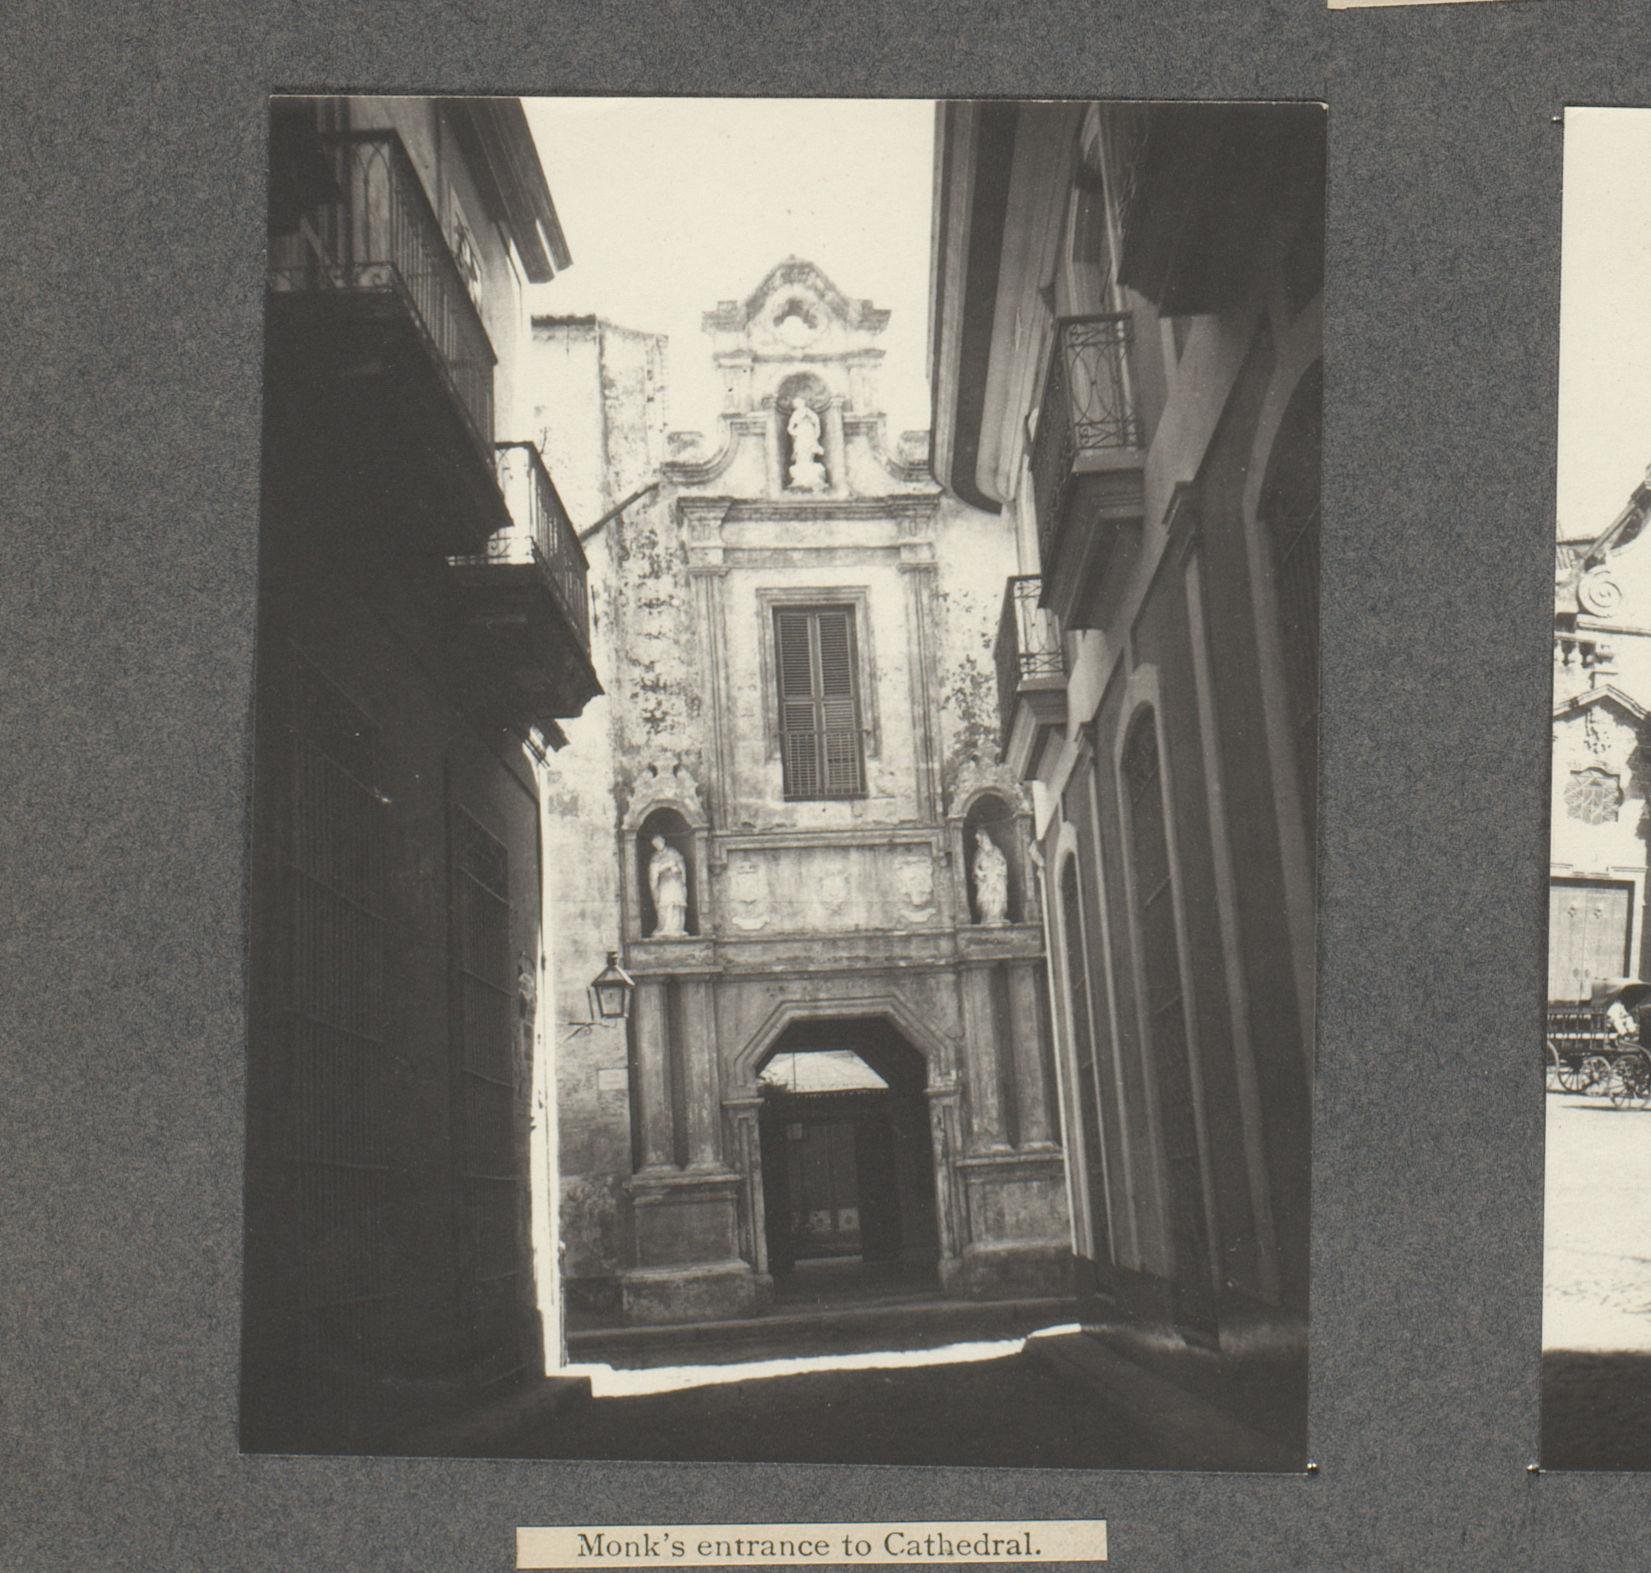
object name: album leaf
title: Monk's entrance to Cathedral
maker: Anonymous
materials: paper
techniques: platinum process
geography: havana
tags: parts of church exterior and annexes: portal